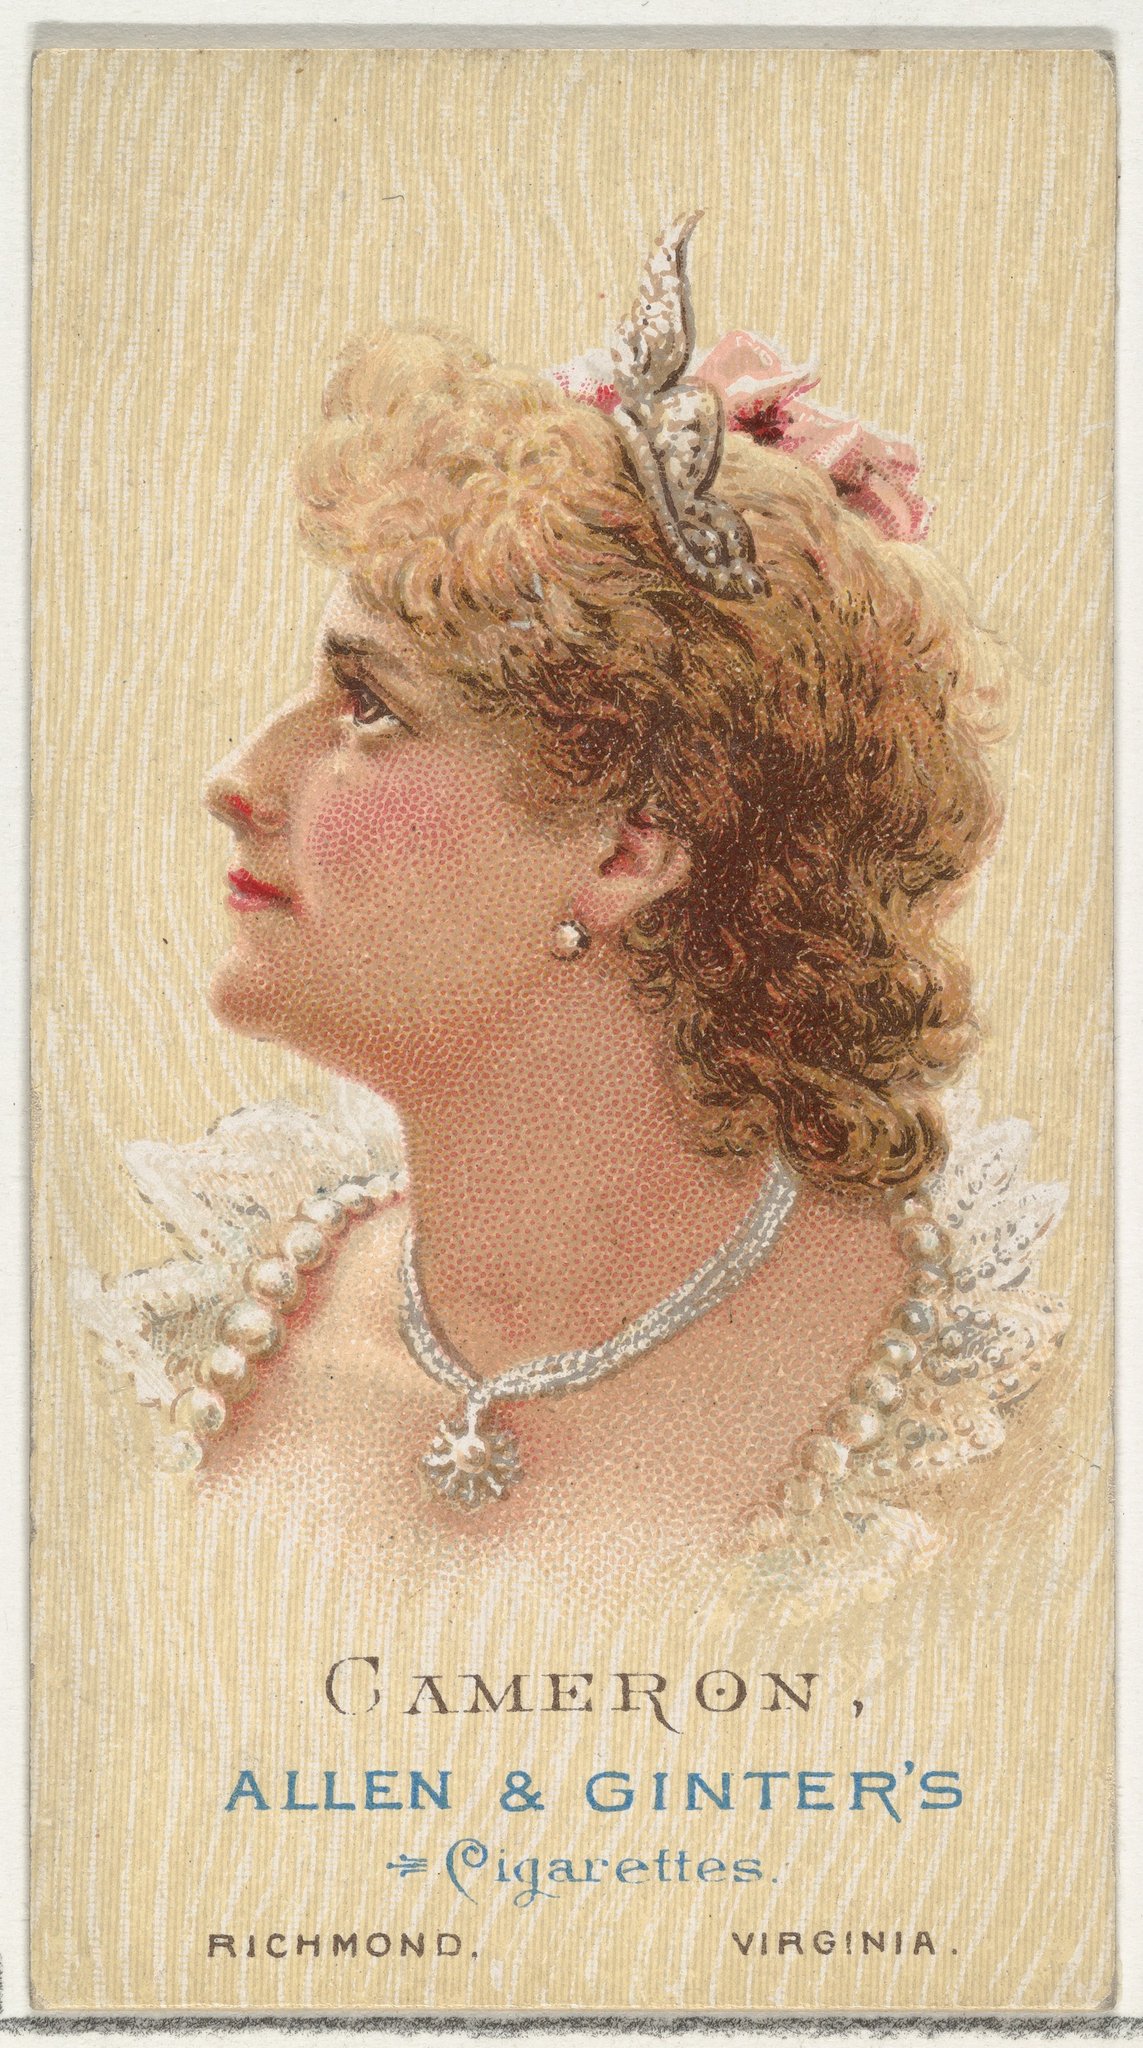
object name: print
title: Cameron, from World's Beauties, Series 2 (N27) for Allen & Ginter Cigarettes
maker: allen & ginter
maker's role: publisher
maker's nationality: american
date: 1888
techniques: color lithograph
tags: women